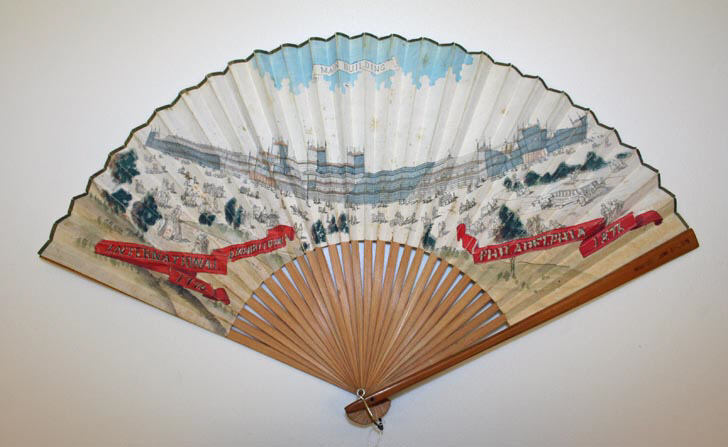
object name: fan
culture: american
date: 1876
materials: bamboo, paper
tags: buildings,flags